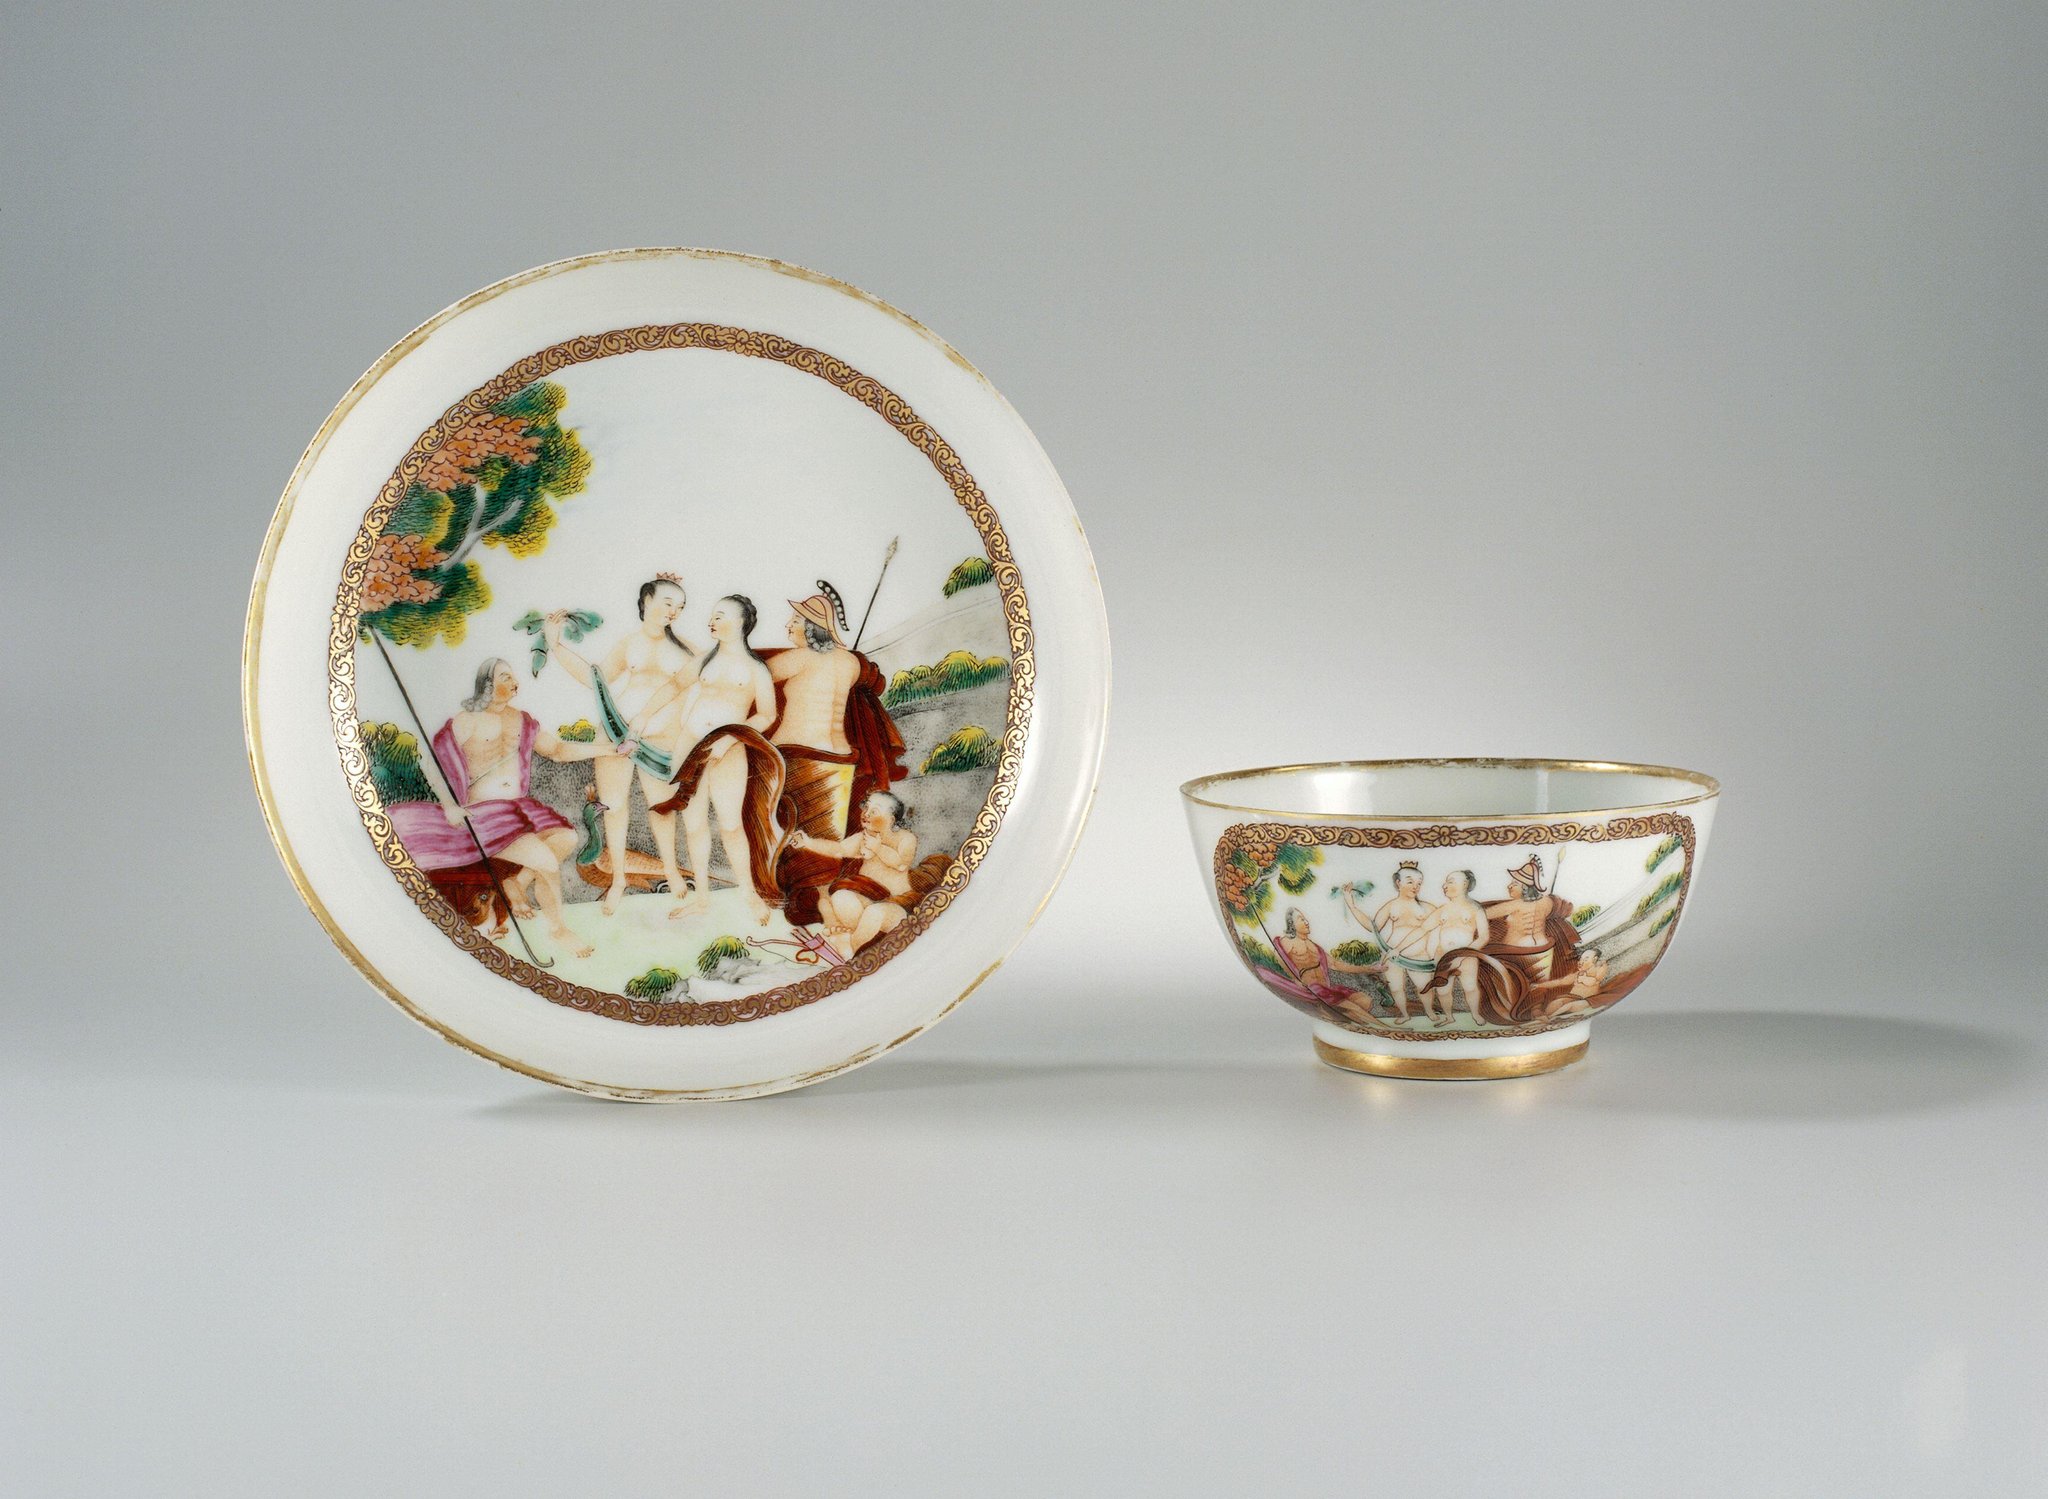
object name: kop en schotel, kop en schotel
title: Saucer with an image of the Judgement op Paris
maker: Anonymous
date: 1725-1749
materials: glaze, gold, paint, porcelain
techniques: firing, gilding, turning, vitrification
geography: china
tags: the judgement of paris (without mercury)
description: Kop en schotel op een voetring, gedecoreerd in emailkleuren met een voorstelling van het Paris-oordeel. Links zit een man op een rots, rechts van hem drie staande vrouwen, allen in klassieke gewaden. Aan de middelste vrouw geeft Paris een appel. Paris is de zoon van de koning van Troje Priamos en zijn vrouw Hekabe, en de broer van Hektor. Het verhaal over het Oordeel van Paris begint bij de bruiloft van Peleus en Thetis. De enige godin die niet is uitgenodigd is Eris, de godin van de tweedracht. Wanneer zij onuitgenodigd toch verschijnt, werpt zij een gouden appel tussen de aanwezigen met het opschrift: voor de schoonste. Er ontstaat een twist tussen Hera, Athena en Aphrodite over wie de schoonste is. Paris moet uiteindelijk als scheidsrechter optreden. Elke godin doet Paris een belofte wanneer de keus op haar zal vallen. Door Hera wordt hem macht beloofd, Athena belooft hem militaire roem. Aprhodite beloofd Paris dat zij hem zal helpen de mooiste vrouw ter wereld voor hem te zoeken, en Paris kiest voor Aphrodite. Op één van zijn reizen ontmoet hij Helena, de mooie vrouw van Menelaos. Paris schaakt Helena en neemt haar mee naar Troje. De verbintenis tussen Paris en Helena zal uiteindelijk leiden tot de Trojaanse oorlog.